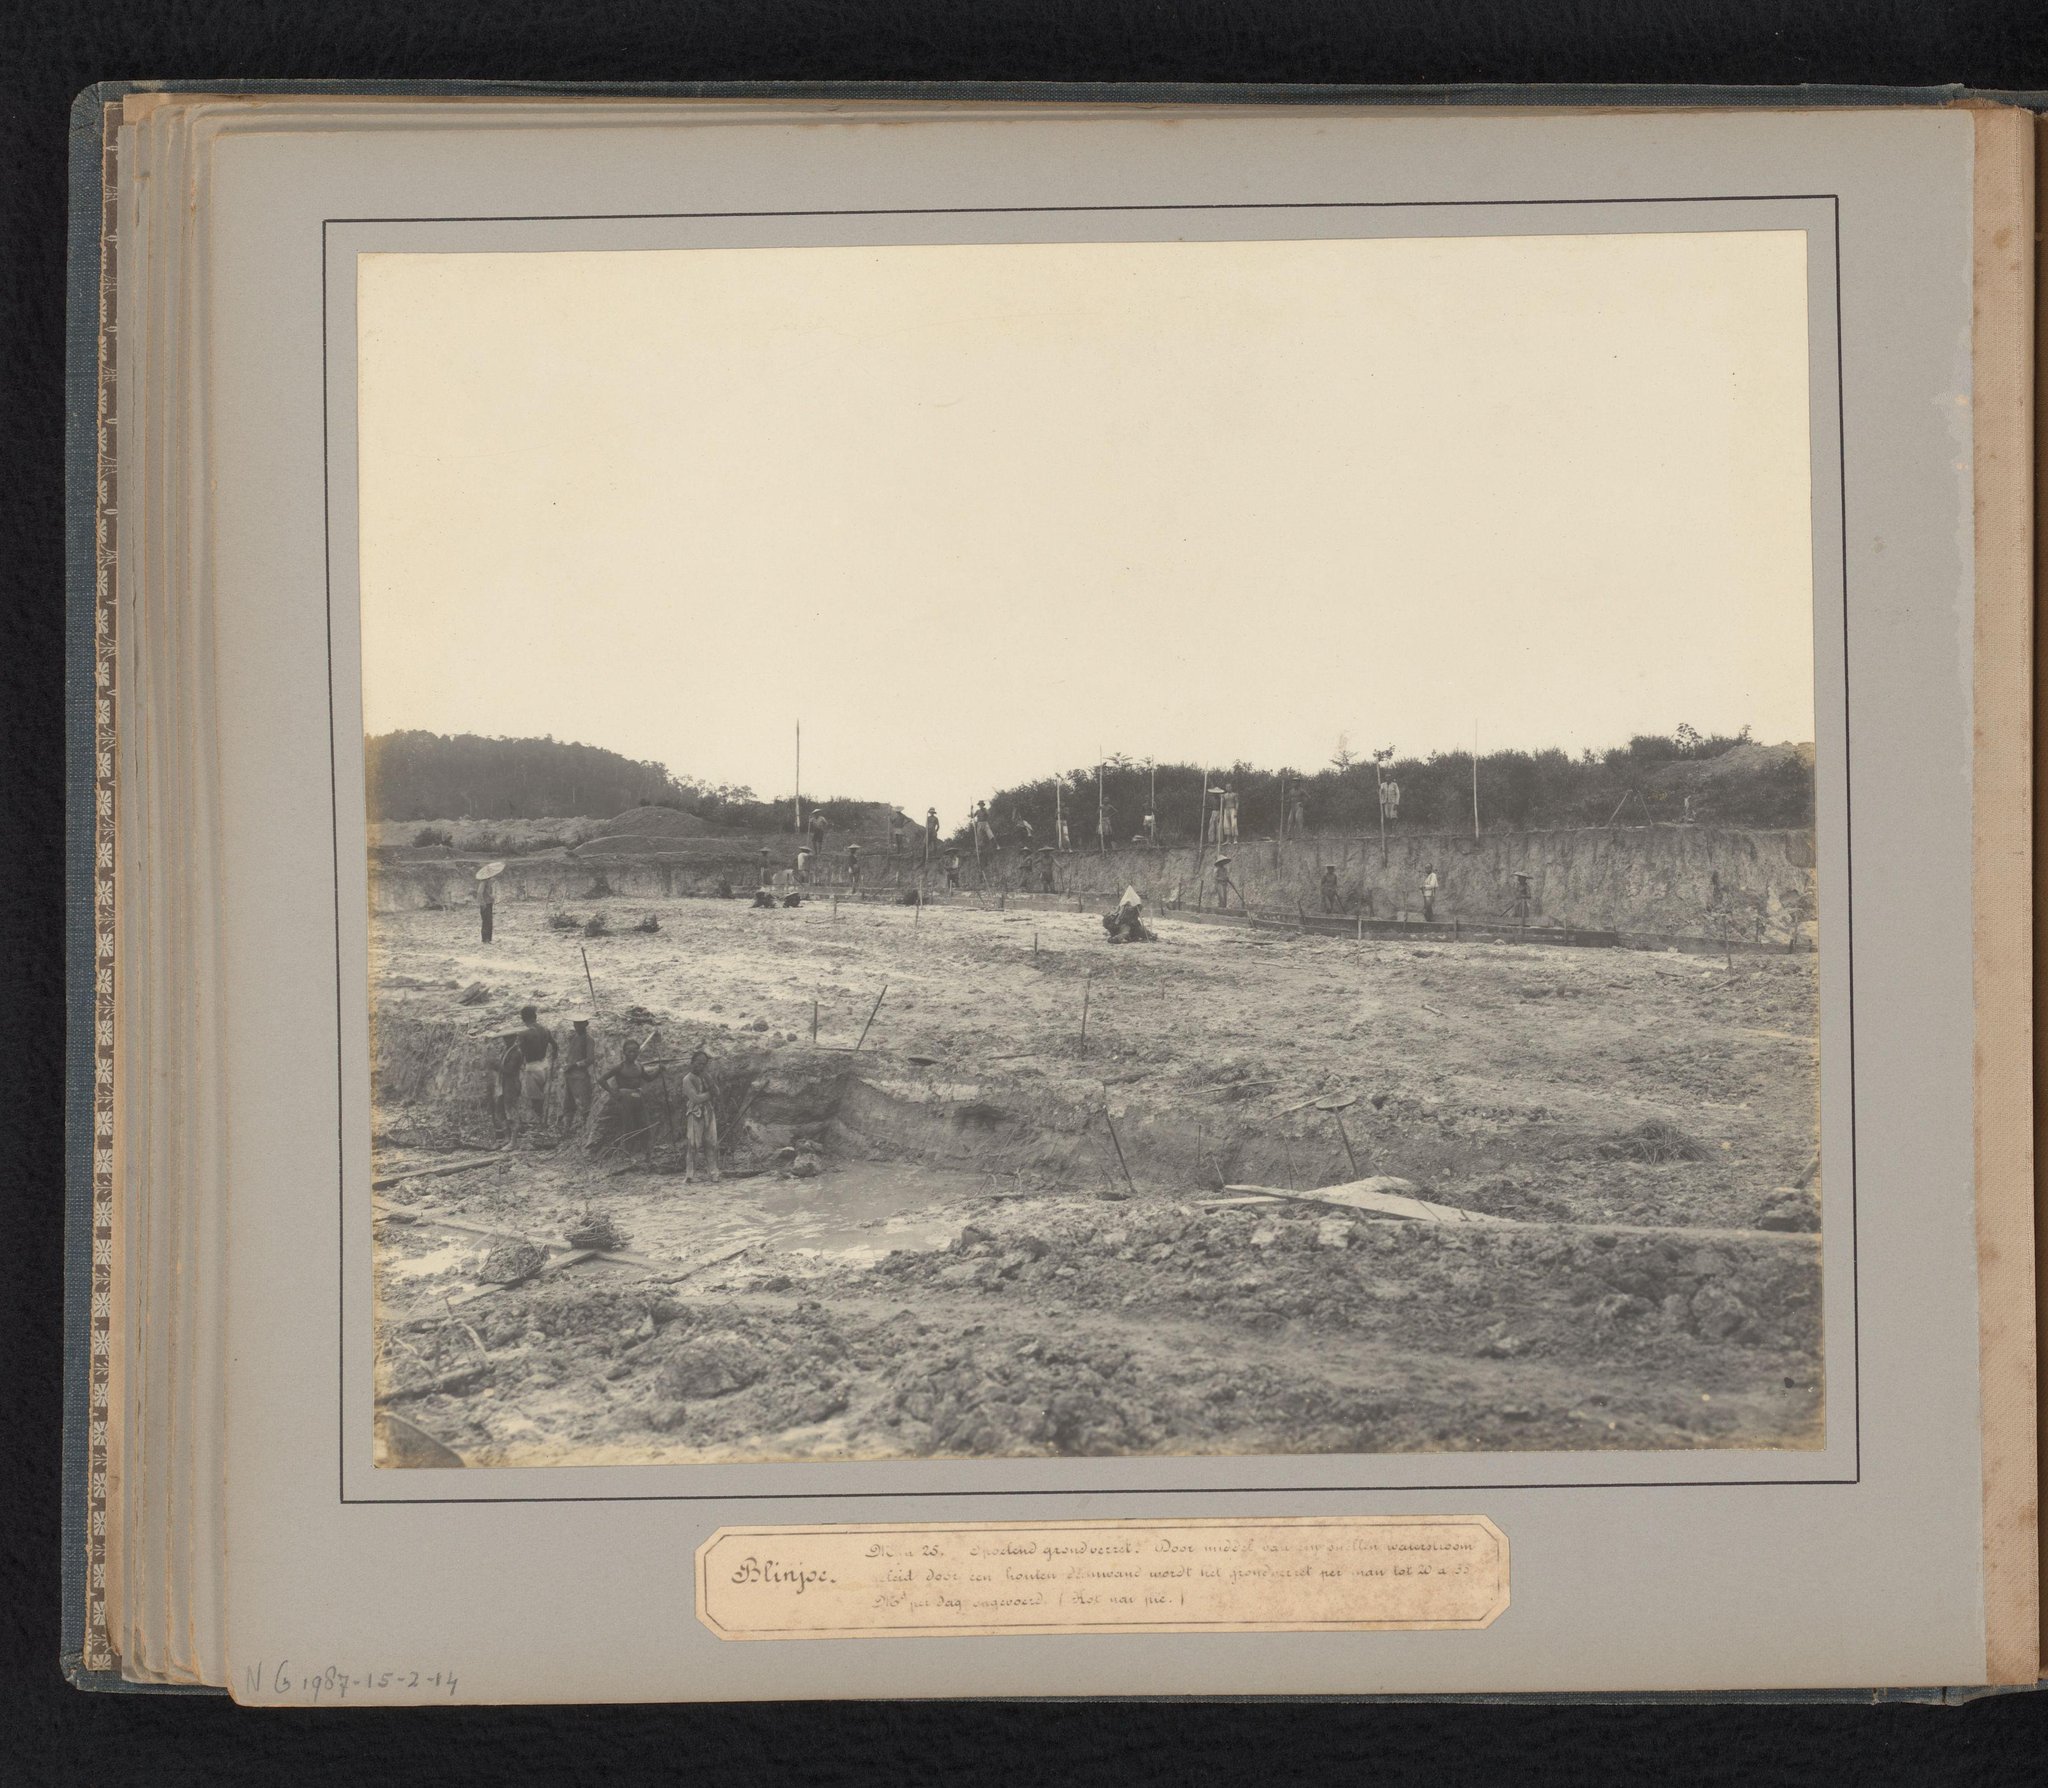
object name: photograph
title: Blinjoe. Mijn 25. Spoelend grondverzet. Door middel van een snellen waterstroom geleid door een houten damwand wordt het grondverzet per man tot 20 a 35 m3 per dag ingevoerd (Kot nai pic)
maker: Anonymous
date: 1907-1919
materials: cardboard, photographic support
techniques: gelatin silver print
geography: bangka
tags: robert julius boers, colonial system, opencast mine; strip mining, minerals and metals: tin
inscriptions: label: ‘Blinjoe. Mijn 25. Spoelend grondverzet. Door middel van een snellen waterstroom geleid door een houten damwand wordt het grondverzet per man tot 20 a 35 m3 per dag ingevoerd (Kot nai pic)’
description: Afspoelen van tinertshoudend grond in een open mijn van de Banka-tinwinning te Belinyu (Blinjoe). Onderdeel van het fotoalbum over de Banka-tinwinning, ca. 1907-1919.